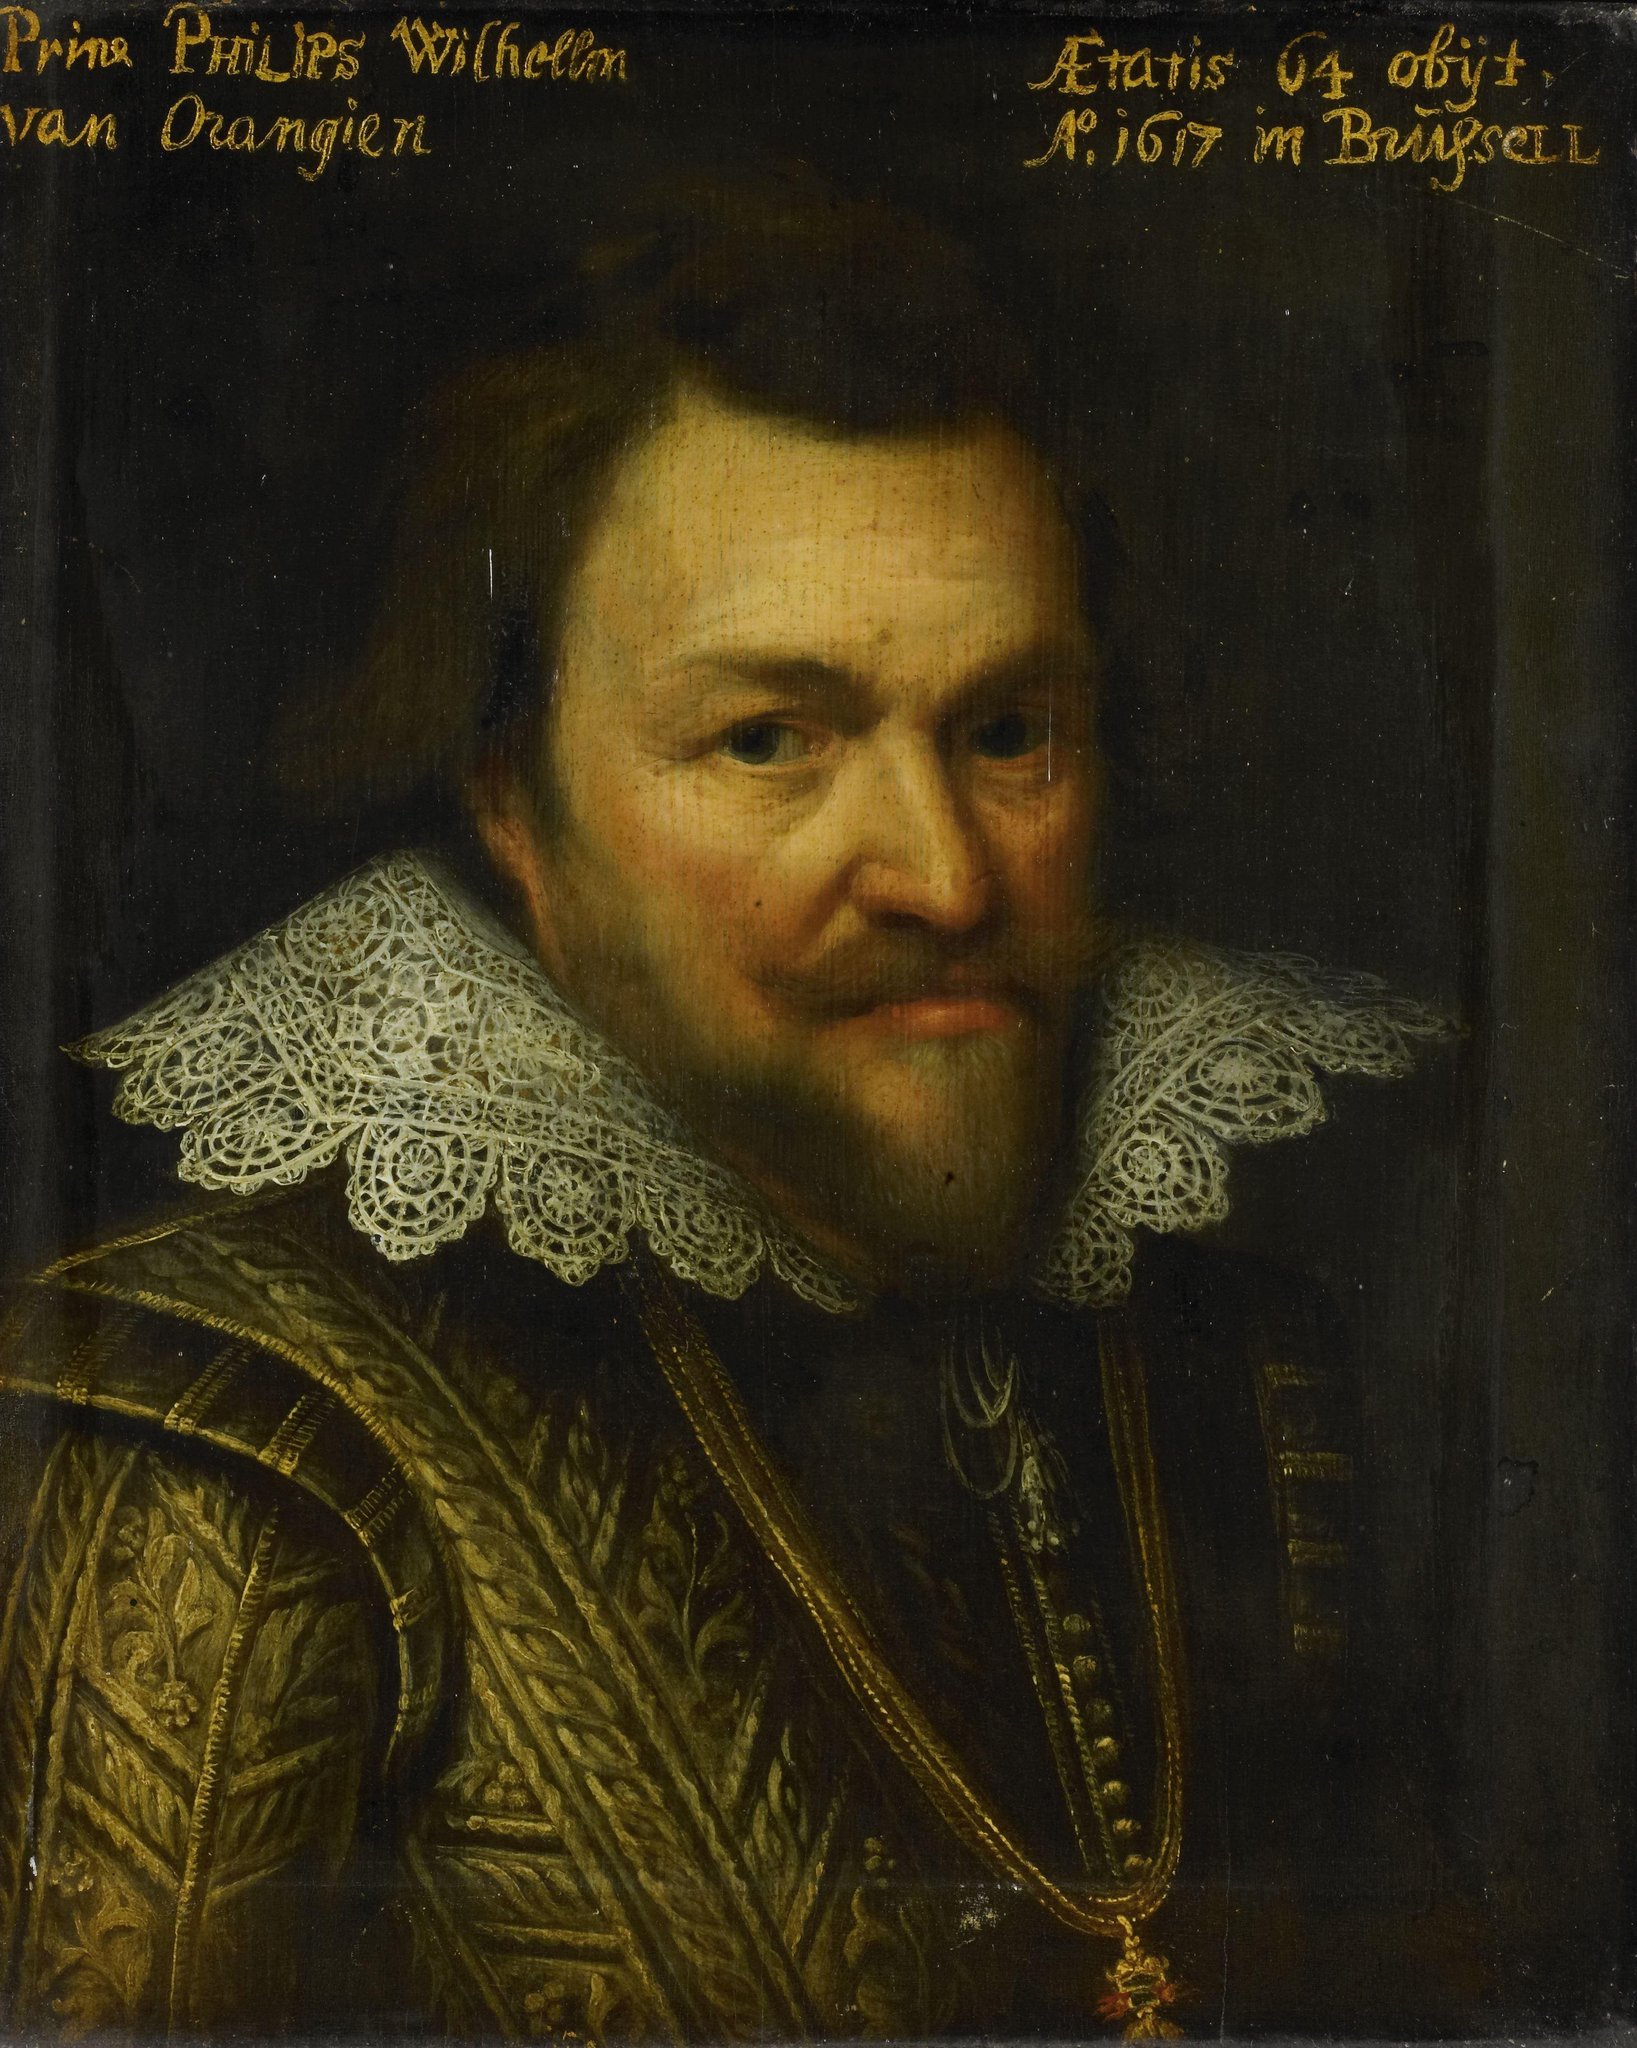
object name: painting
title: Portrait of Philips Willem (1554-1618), Prince of Orange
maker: michiel jansz van mierevelt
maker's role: draughtsman, painter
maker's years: 1567-1641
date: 1609-1633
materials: oil, panel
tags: buren, filips willem (prins van oranje), historical persons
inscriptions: inscription, upper left and right: ‘Prins Philips Wilhellm van Orangien / Ætatis 64 obijt. Aº. 1617 in Brussell’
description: These portraits were originally displayed at Honselaarsdijk, the palace built by Stadholder Frederick Henry and his wife Amalia in the 1620s near The Hague. In the style of European courts of the day, one of the palace rooms was lined with portraits of ancestors, relatives and celebrities past and present. Many of these personalities played a role in the Eighty Years War: members of the Nassau family and other commanders of the Dutch Republic's army, officers of the French and English allies and leading Spanish generals. A remarkable aspect is the number of foreigners who fought for the Dutch. The Republic's army enjoyed an international reputation and attracted young noblemen from abroad. For them, the war was a career opportunity.